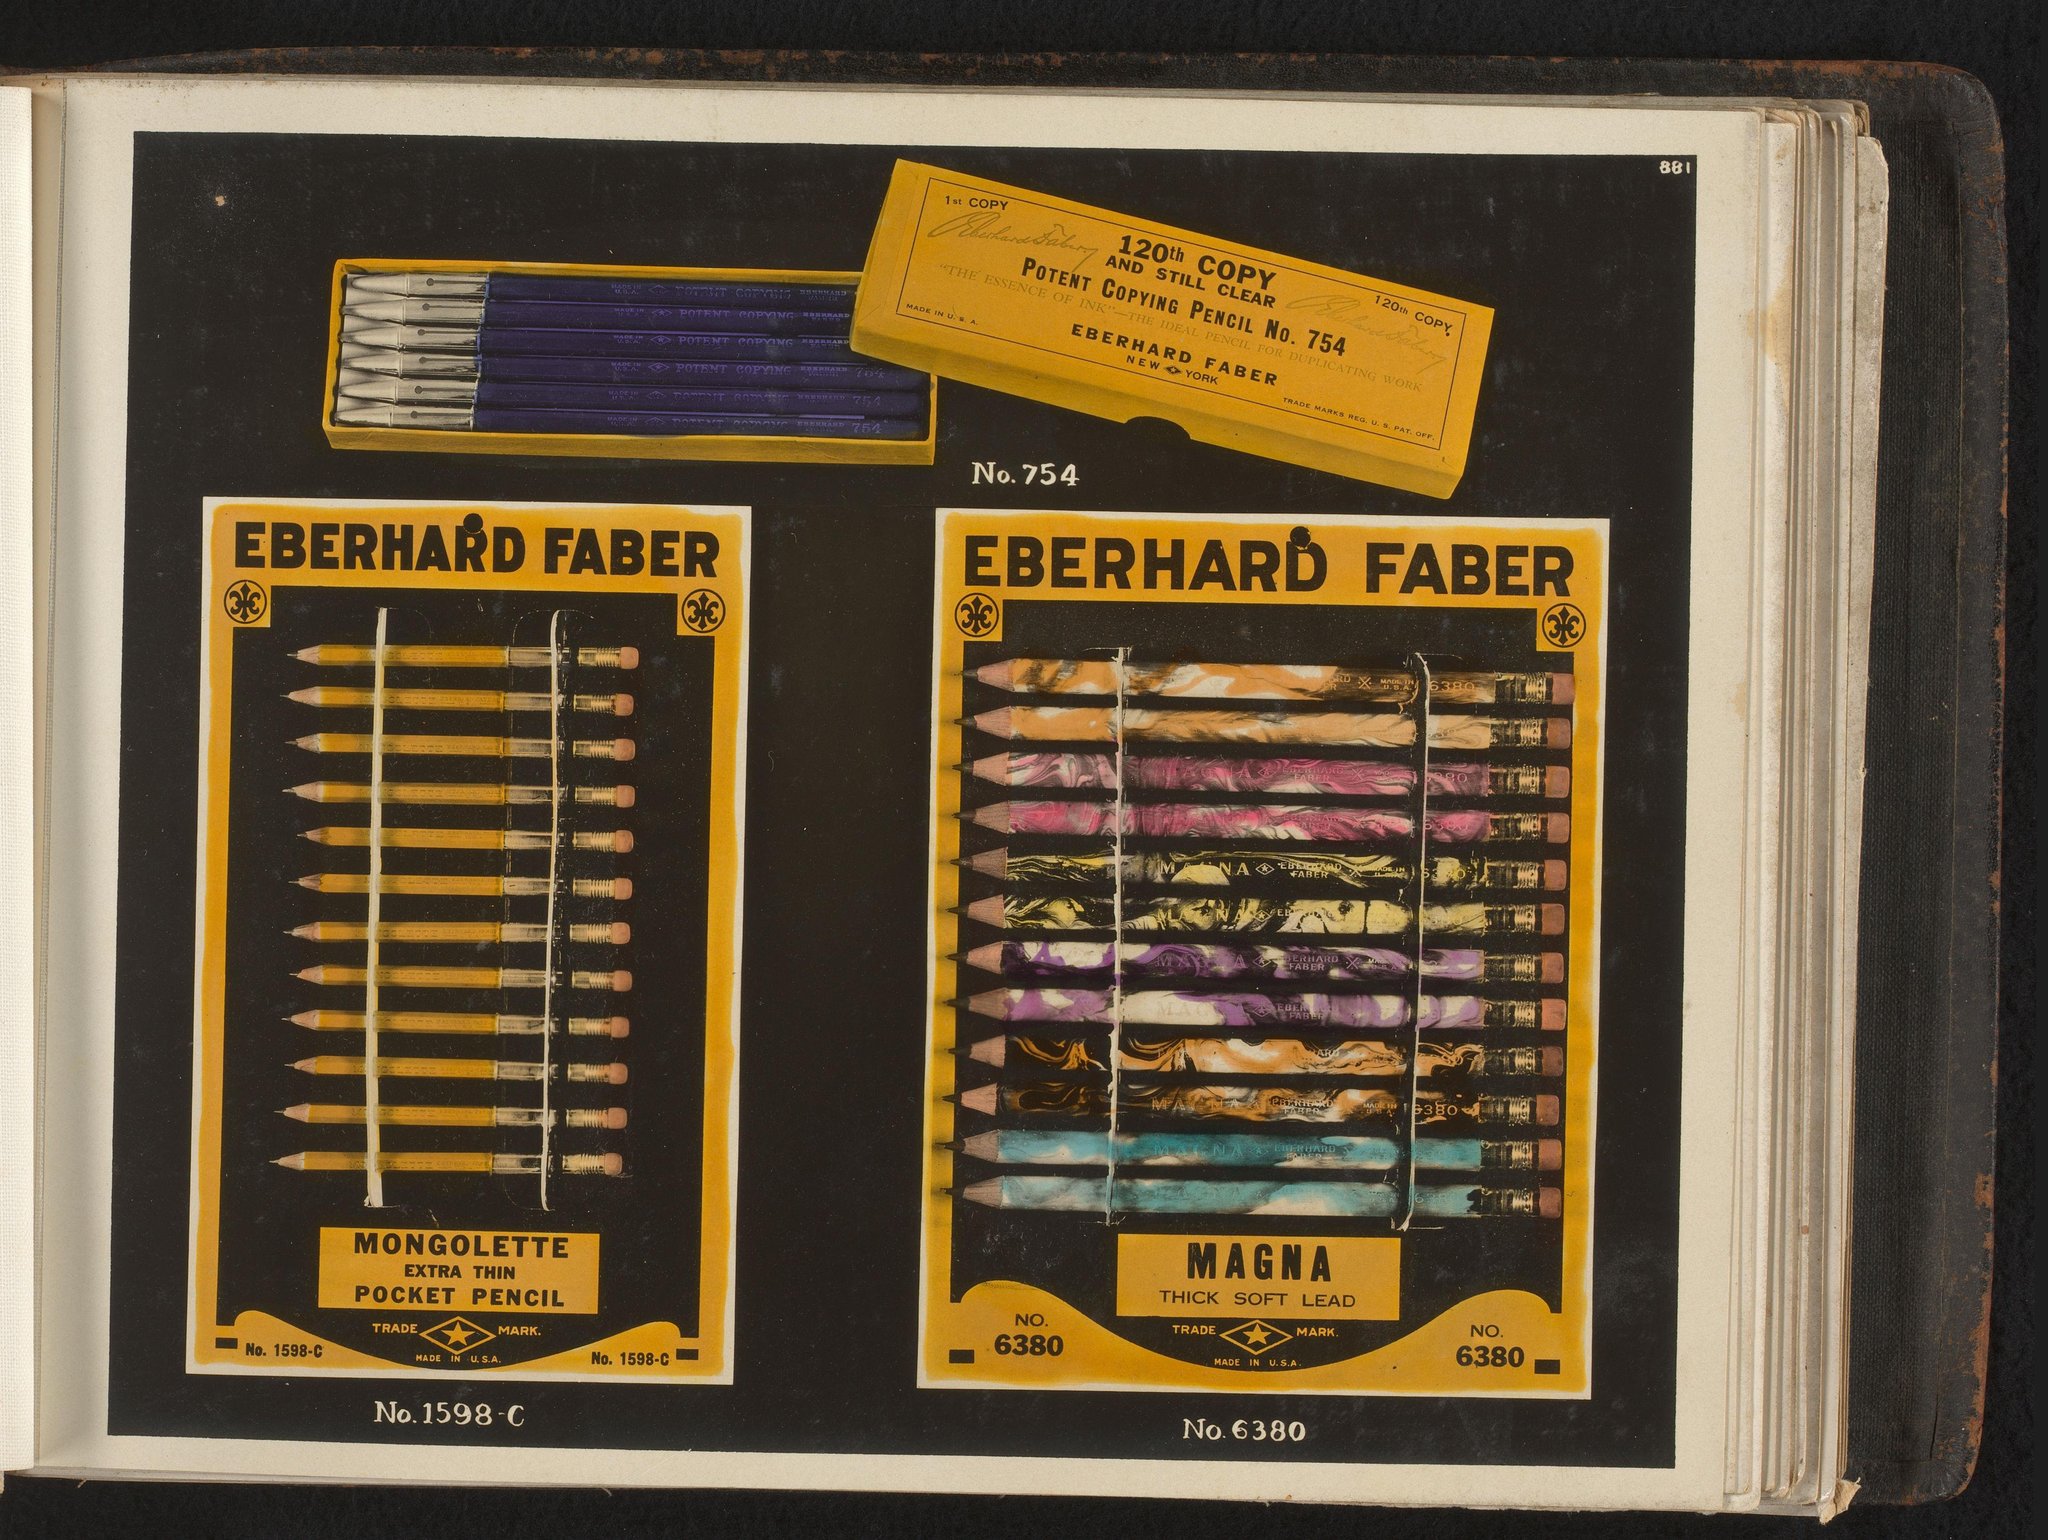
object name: album leaf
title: Sets met potloden van Eberhard Faber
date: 1915-1935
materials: paper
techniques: gelatin silver print, hand coloring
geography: springfield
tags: pencil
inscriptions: number: ‘881’, stamp: ‘Paramount/ Commercial Studios/ 145 Chestnut St./ Springfield - Mass.’